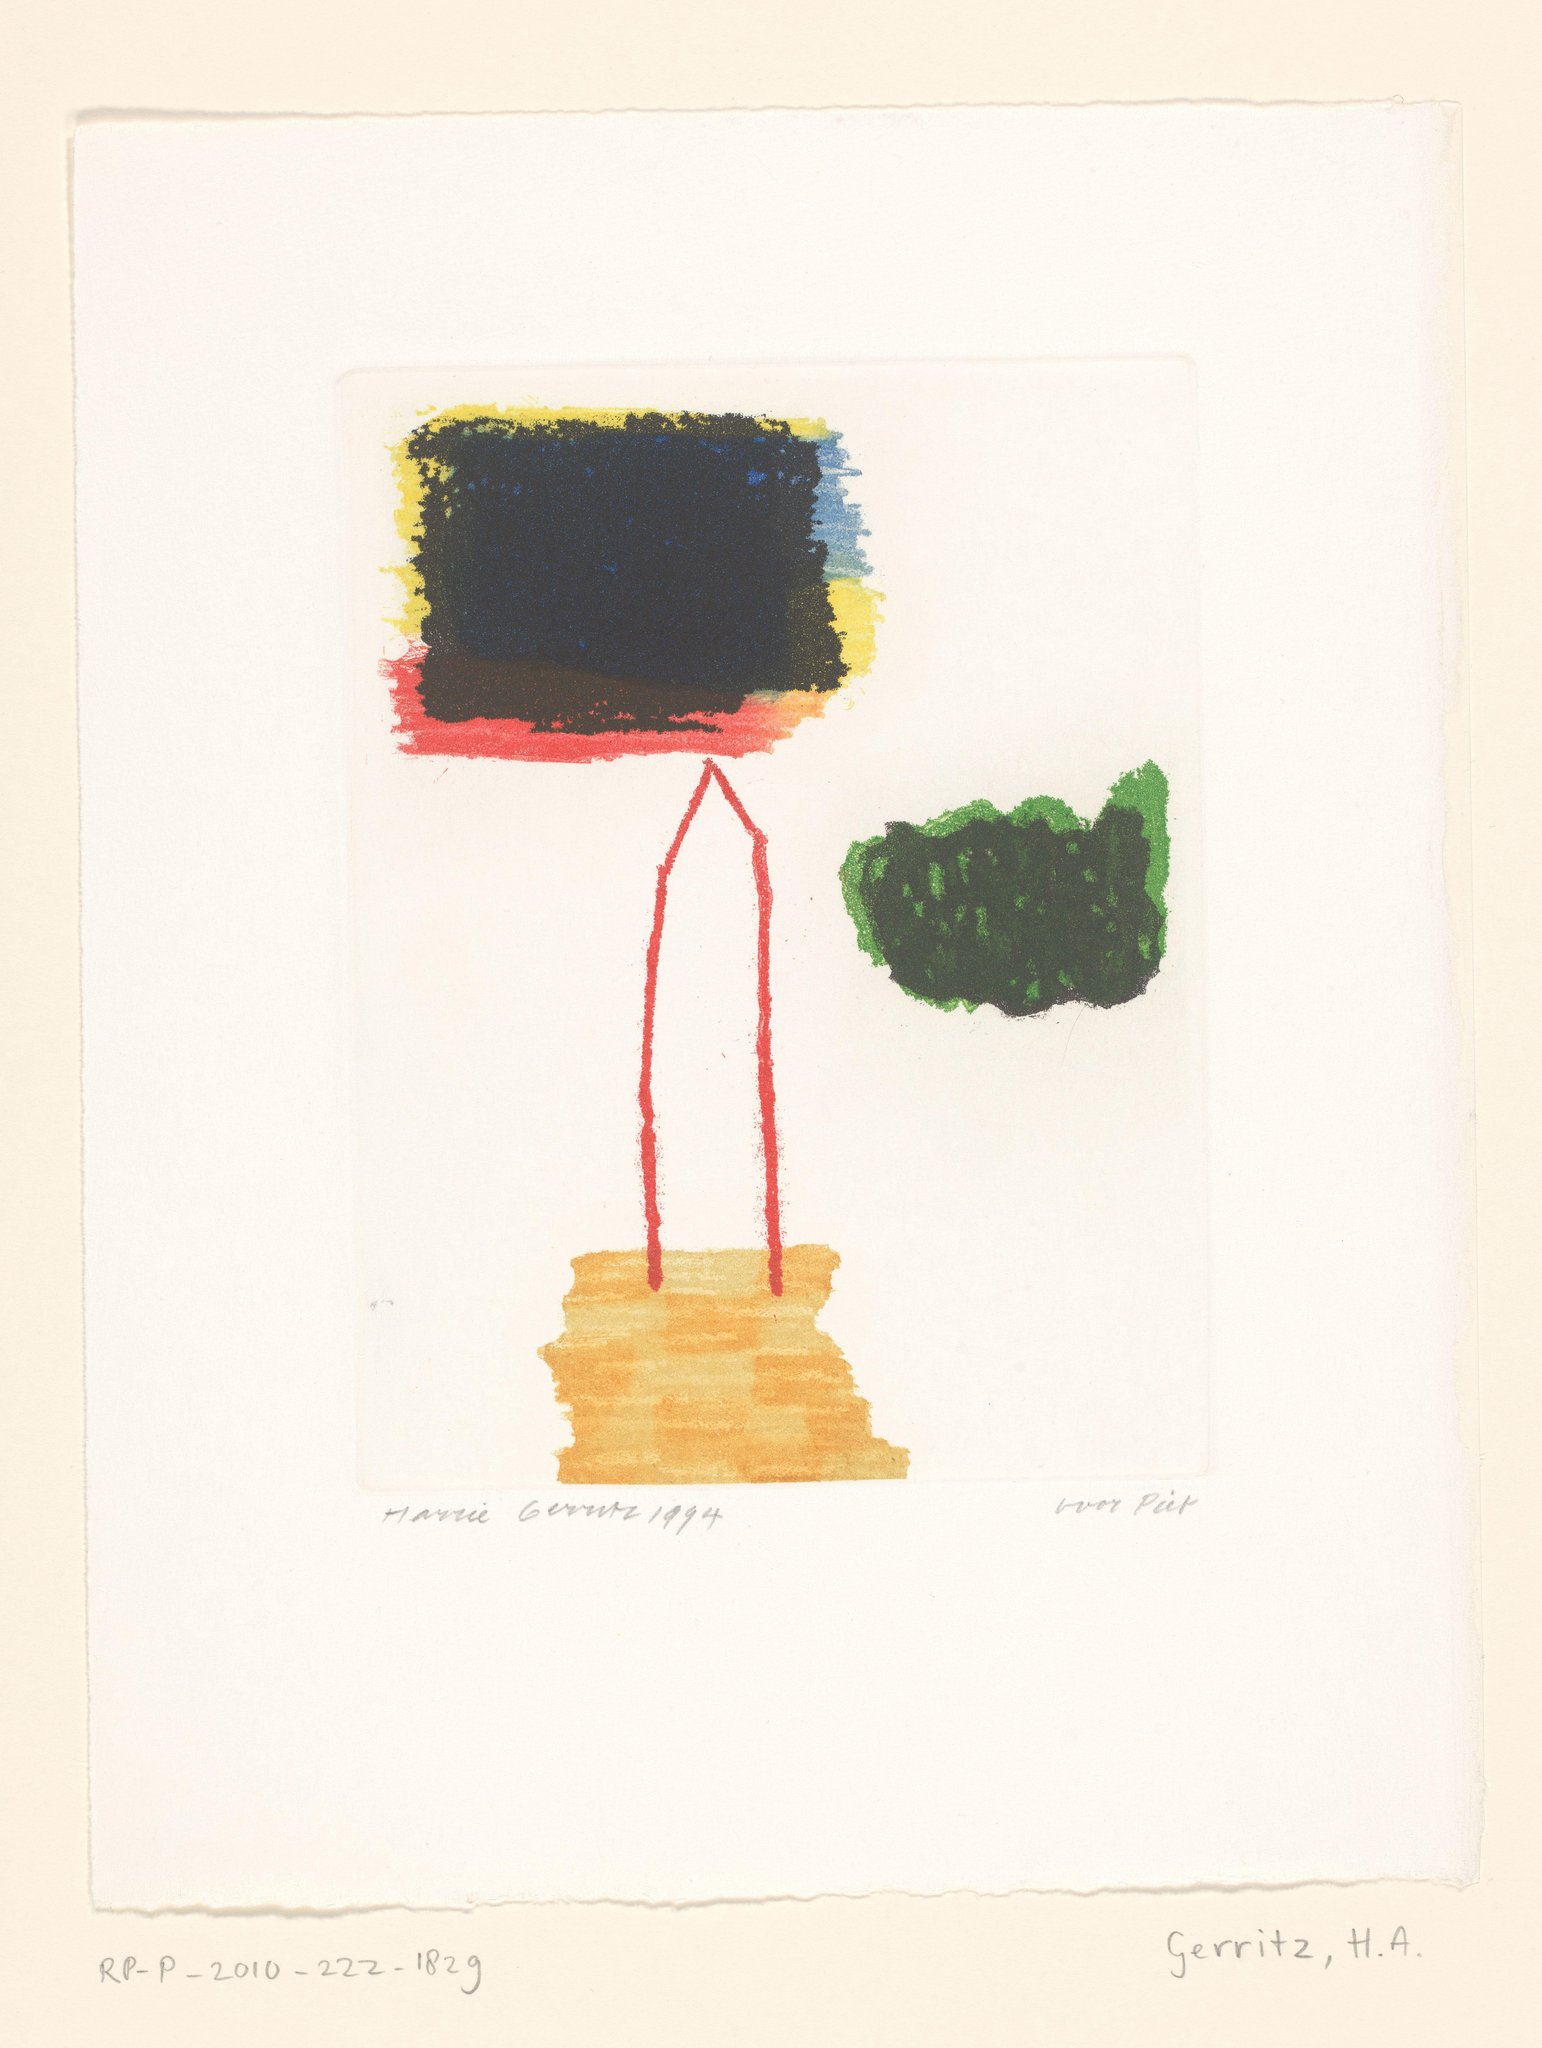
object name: print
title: Rode toren, zwart vlak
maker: harrie a. gerritz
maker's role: draughtsman, painter, print maker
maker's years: 1940-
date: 1994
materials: paper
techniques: aquatint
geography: amsterdam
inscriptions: signature and date: ‘Harrie Gerritz 1994’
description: Rode toren onder, zwart vlak over een gele, rode en blauwe baan boven.